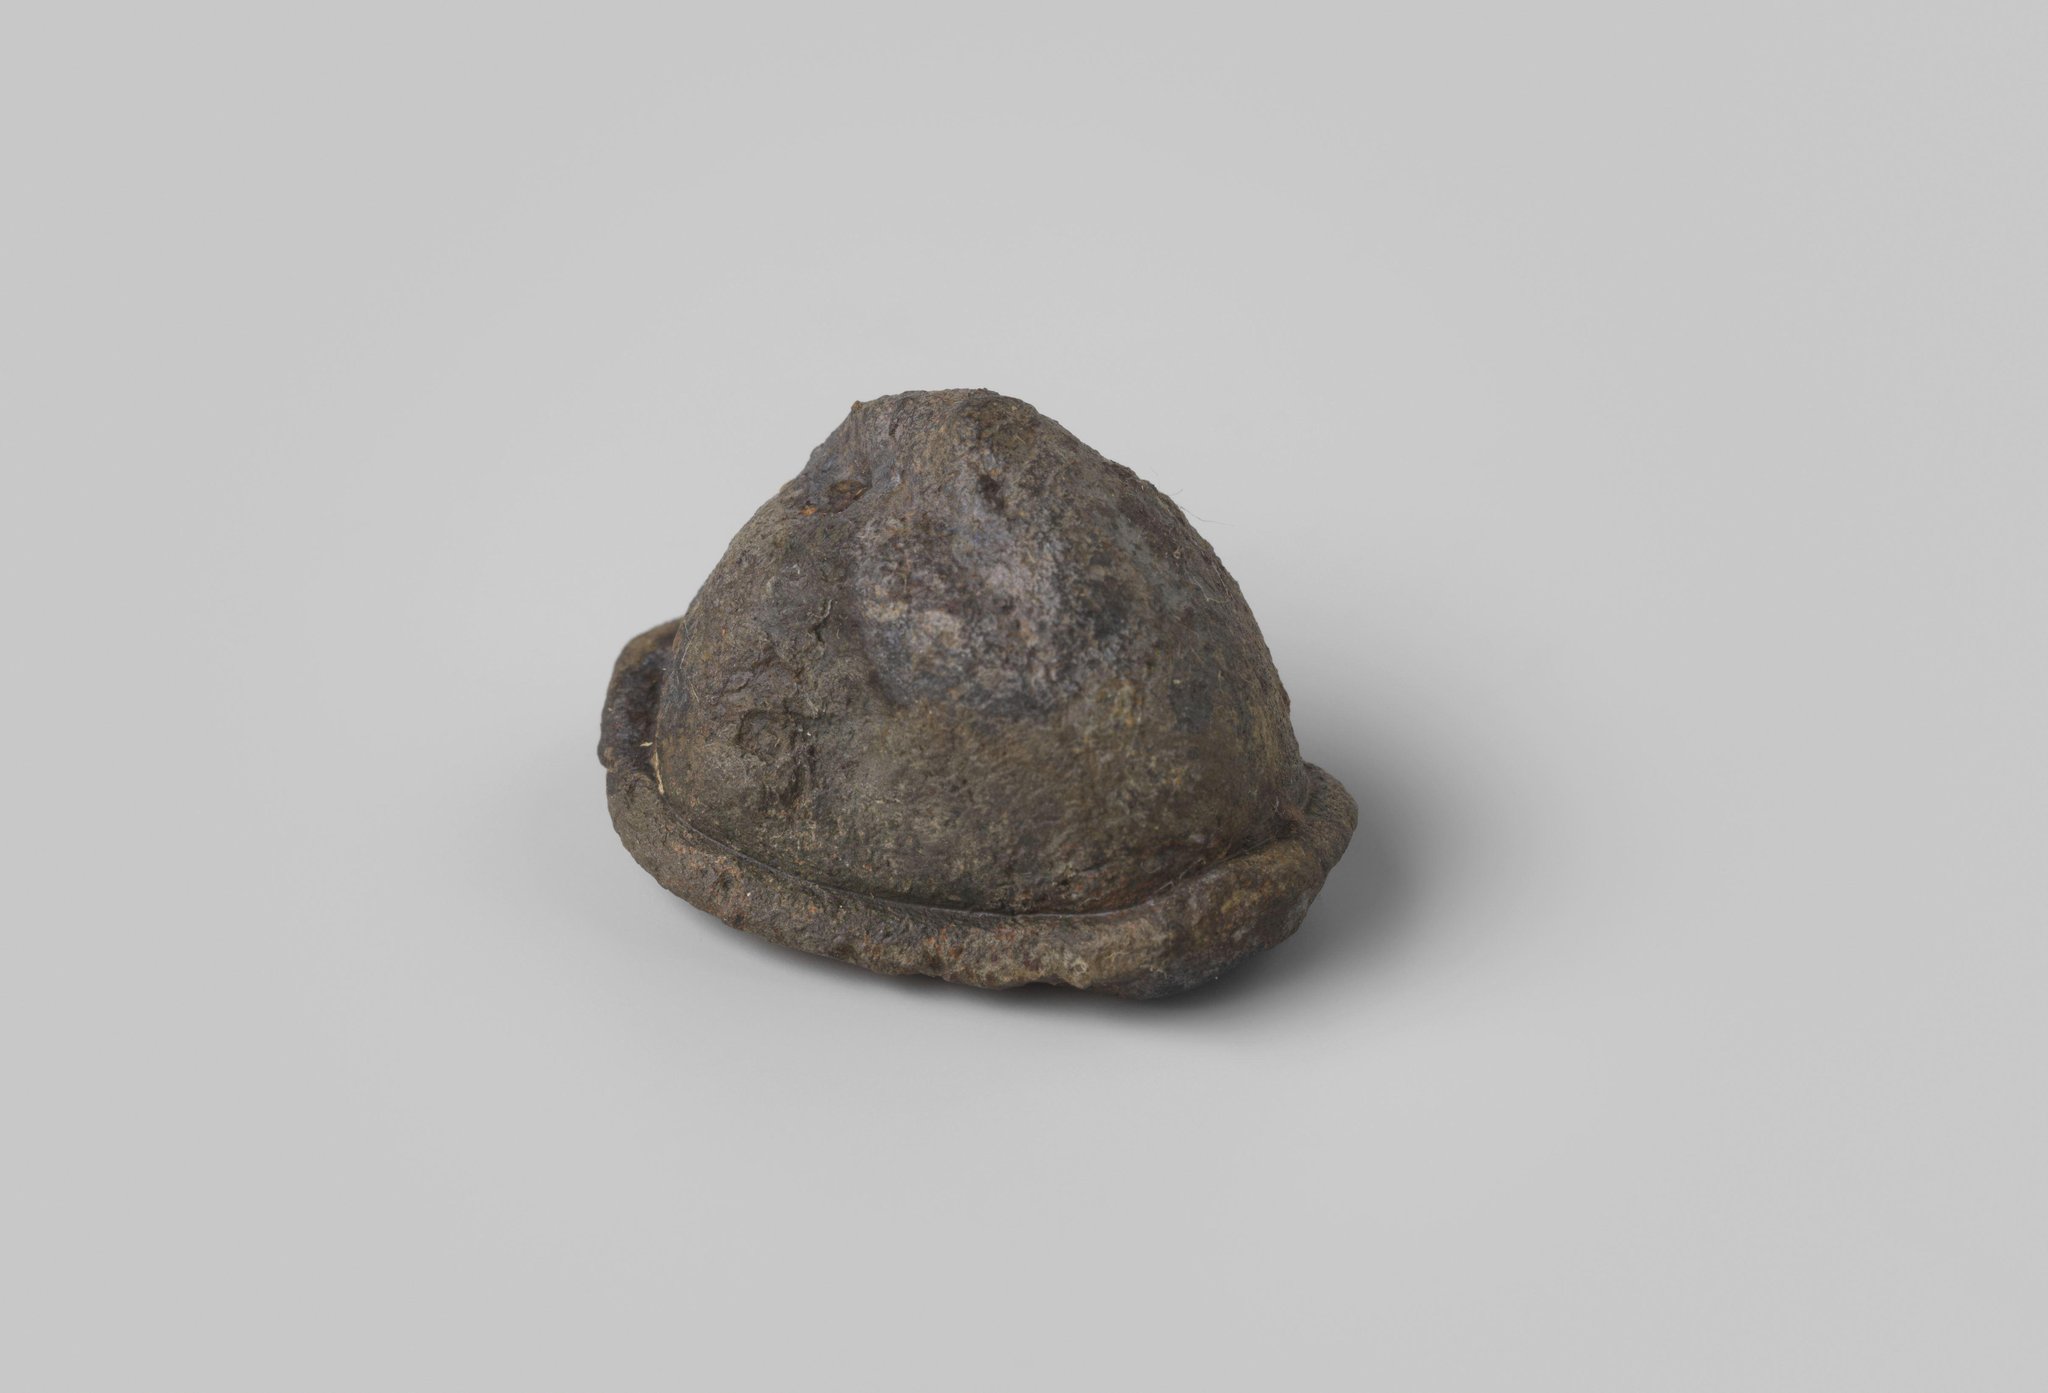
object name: lid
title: Deksel van een verpakking uit het wrak van de Oost-Indiëvaarder Hollandia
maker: Anonymous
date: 1700-1743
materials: tin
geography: netherlands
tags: verenigde oostindische compagnie, hollandia (schip), annet